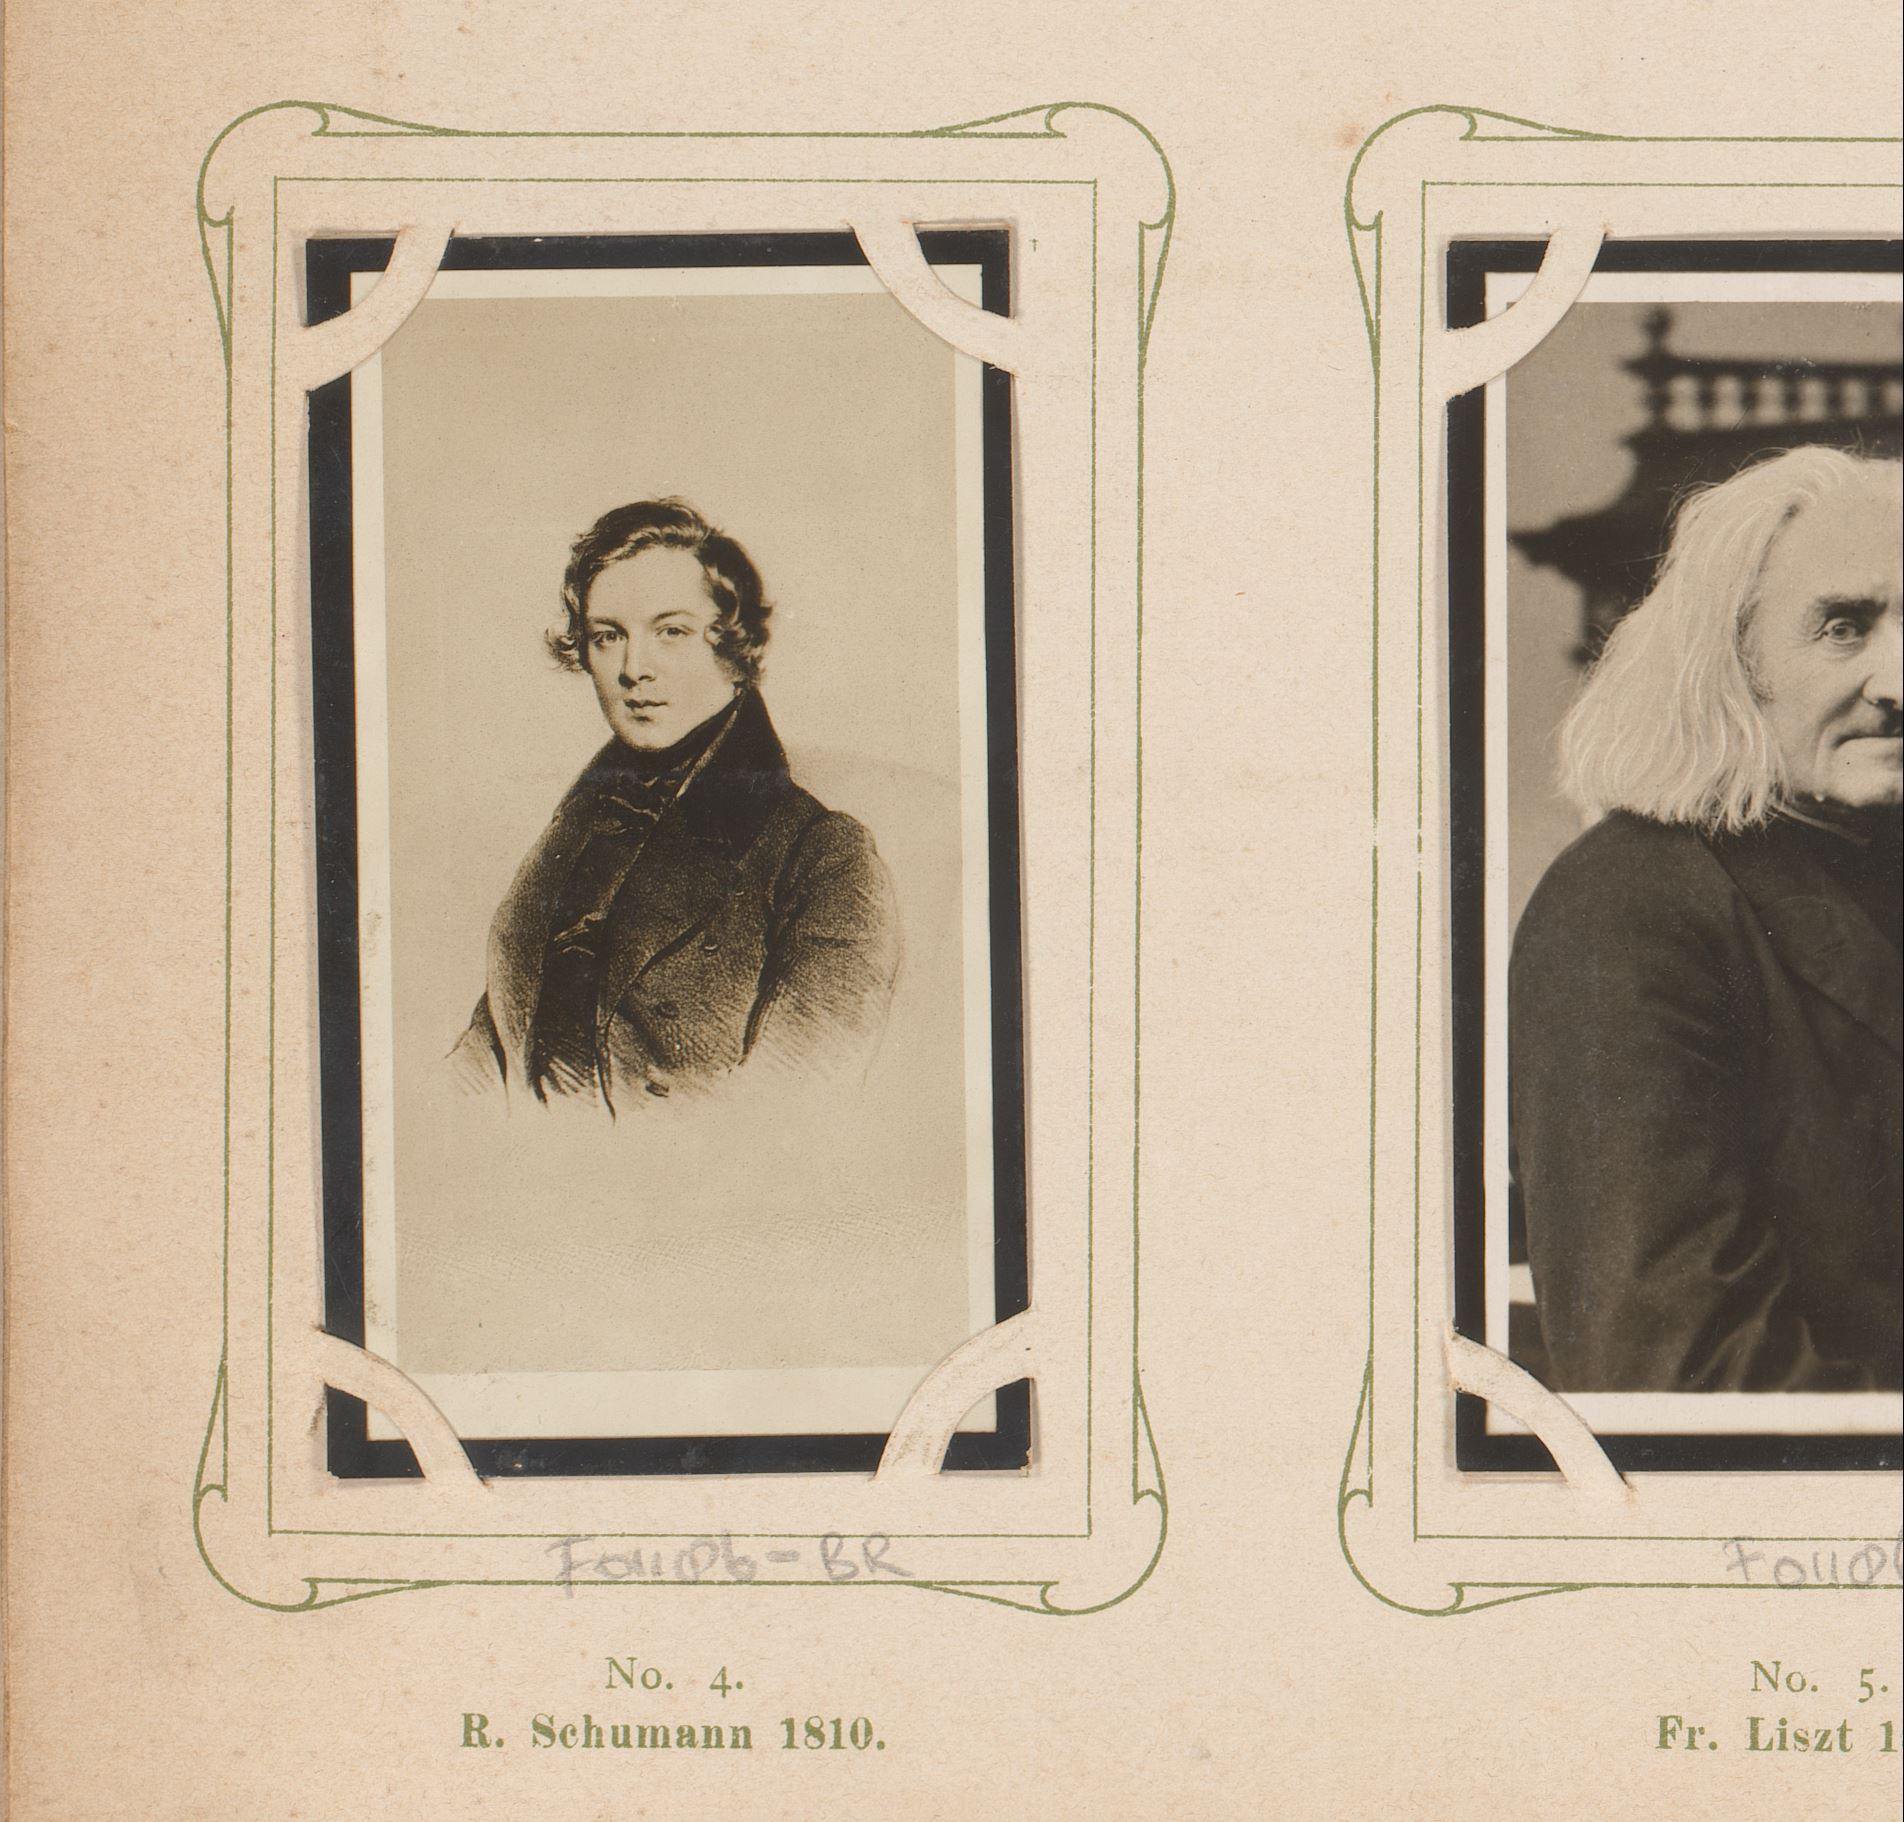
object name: photograph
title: Fotoreproductie van een geschilderd portret van Robert Schumann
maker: Anonymous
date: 1904-1905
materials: photographic support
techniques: gelatin silver print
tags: zwickau, robert schumann, historical persons, portrait of composer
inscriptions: inscription: ‘No. 4./ R. Schumann 1810’